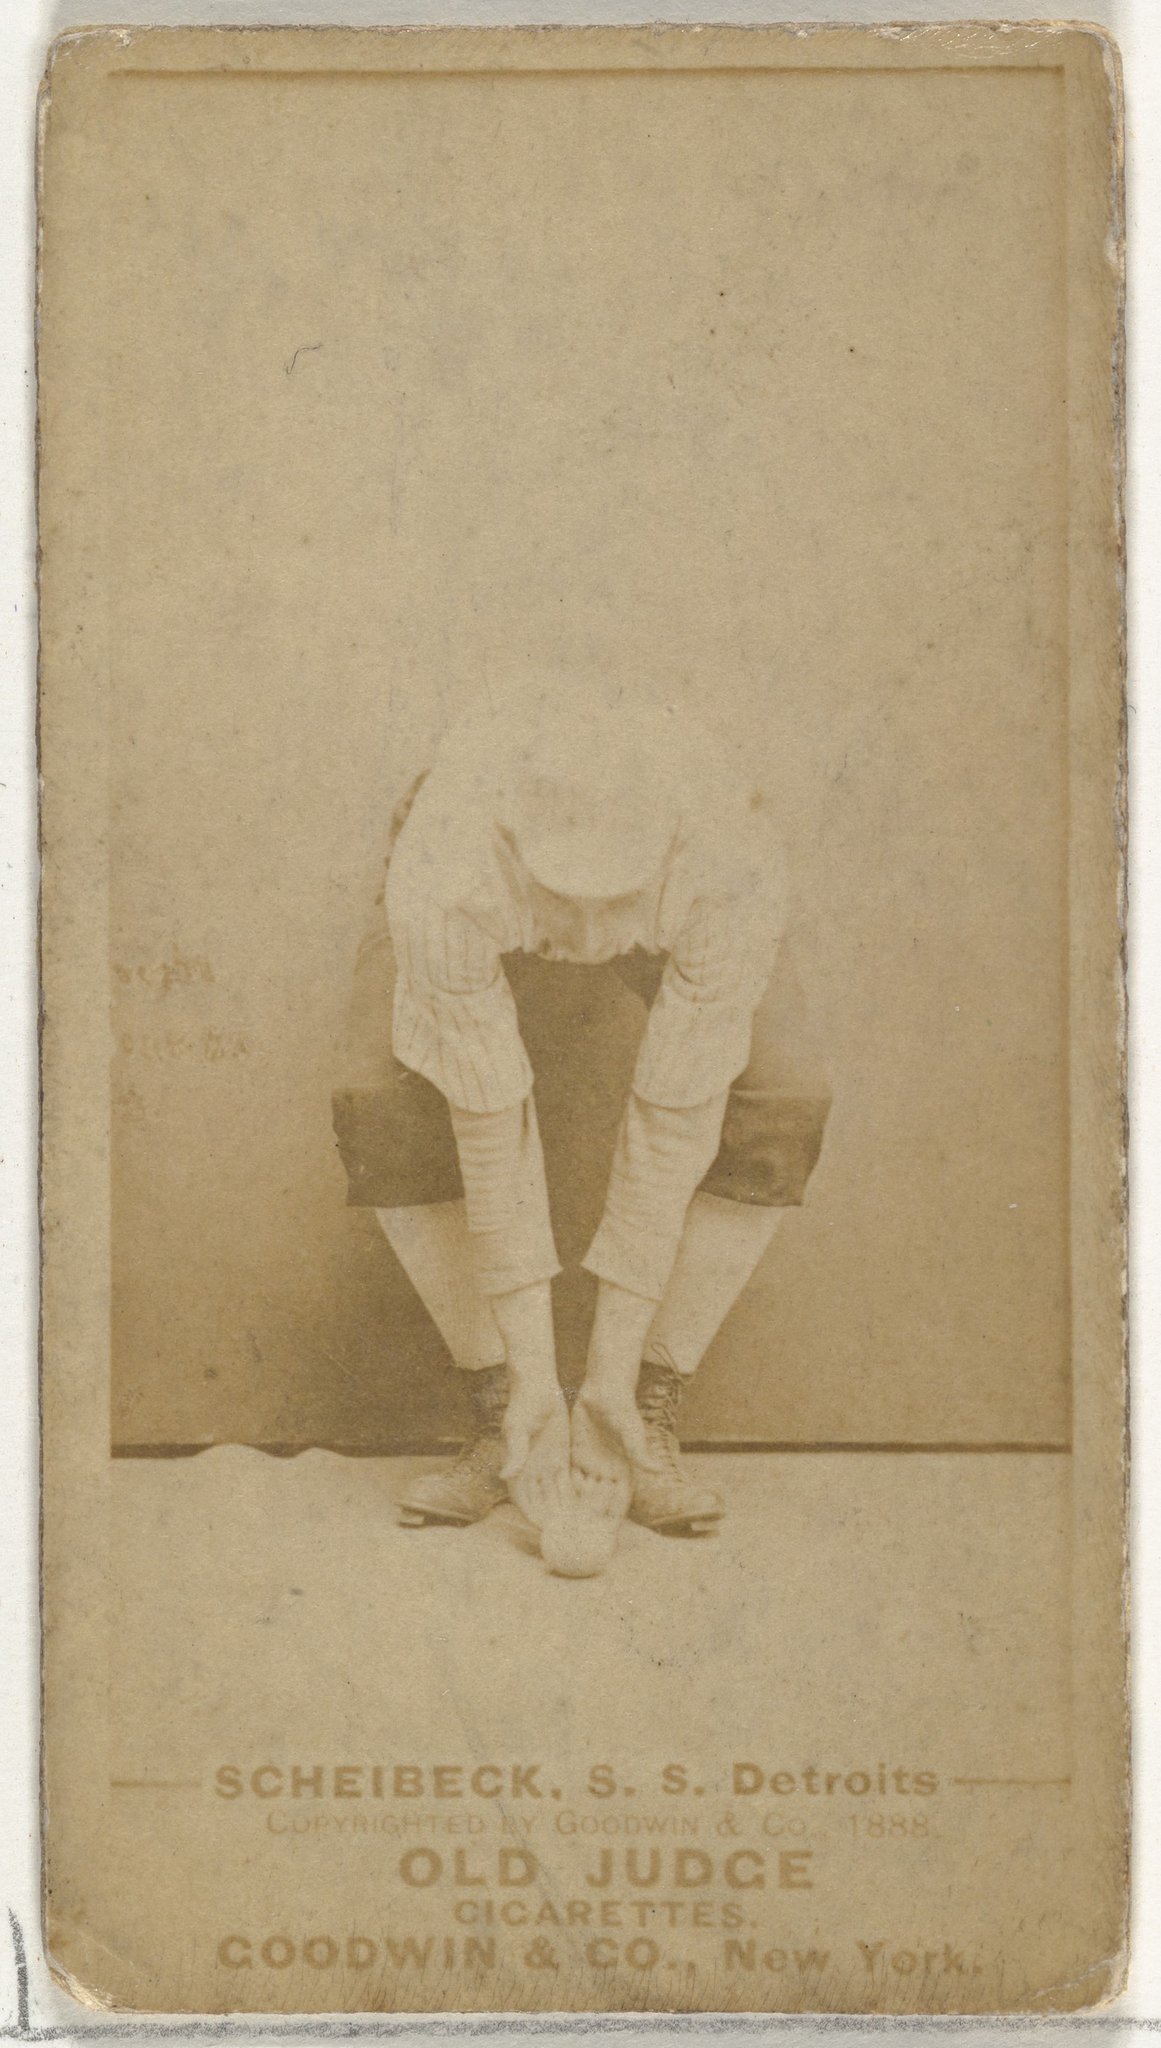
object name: baseball card, photograph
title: Frank Scheibeck, Shortstop, Detroit Wolverines, from the Old Judge series (N172) for Old Judge Cigarettes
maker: goodwin & company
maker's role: publisher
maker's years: 1850-1950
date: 1888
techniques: albumen silver print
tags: men,portraits,baseball,athletes